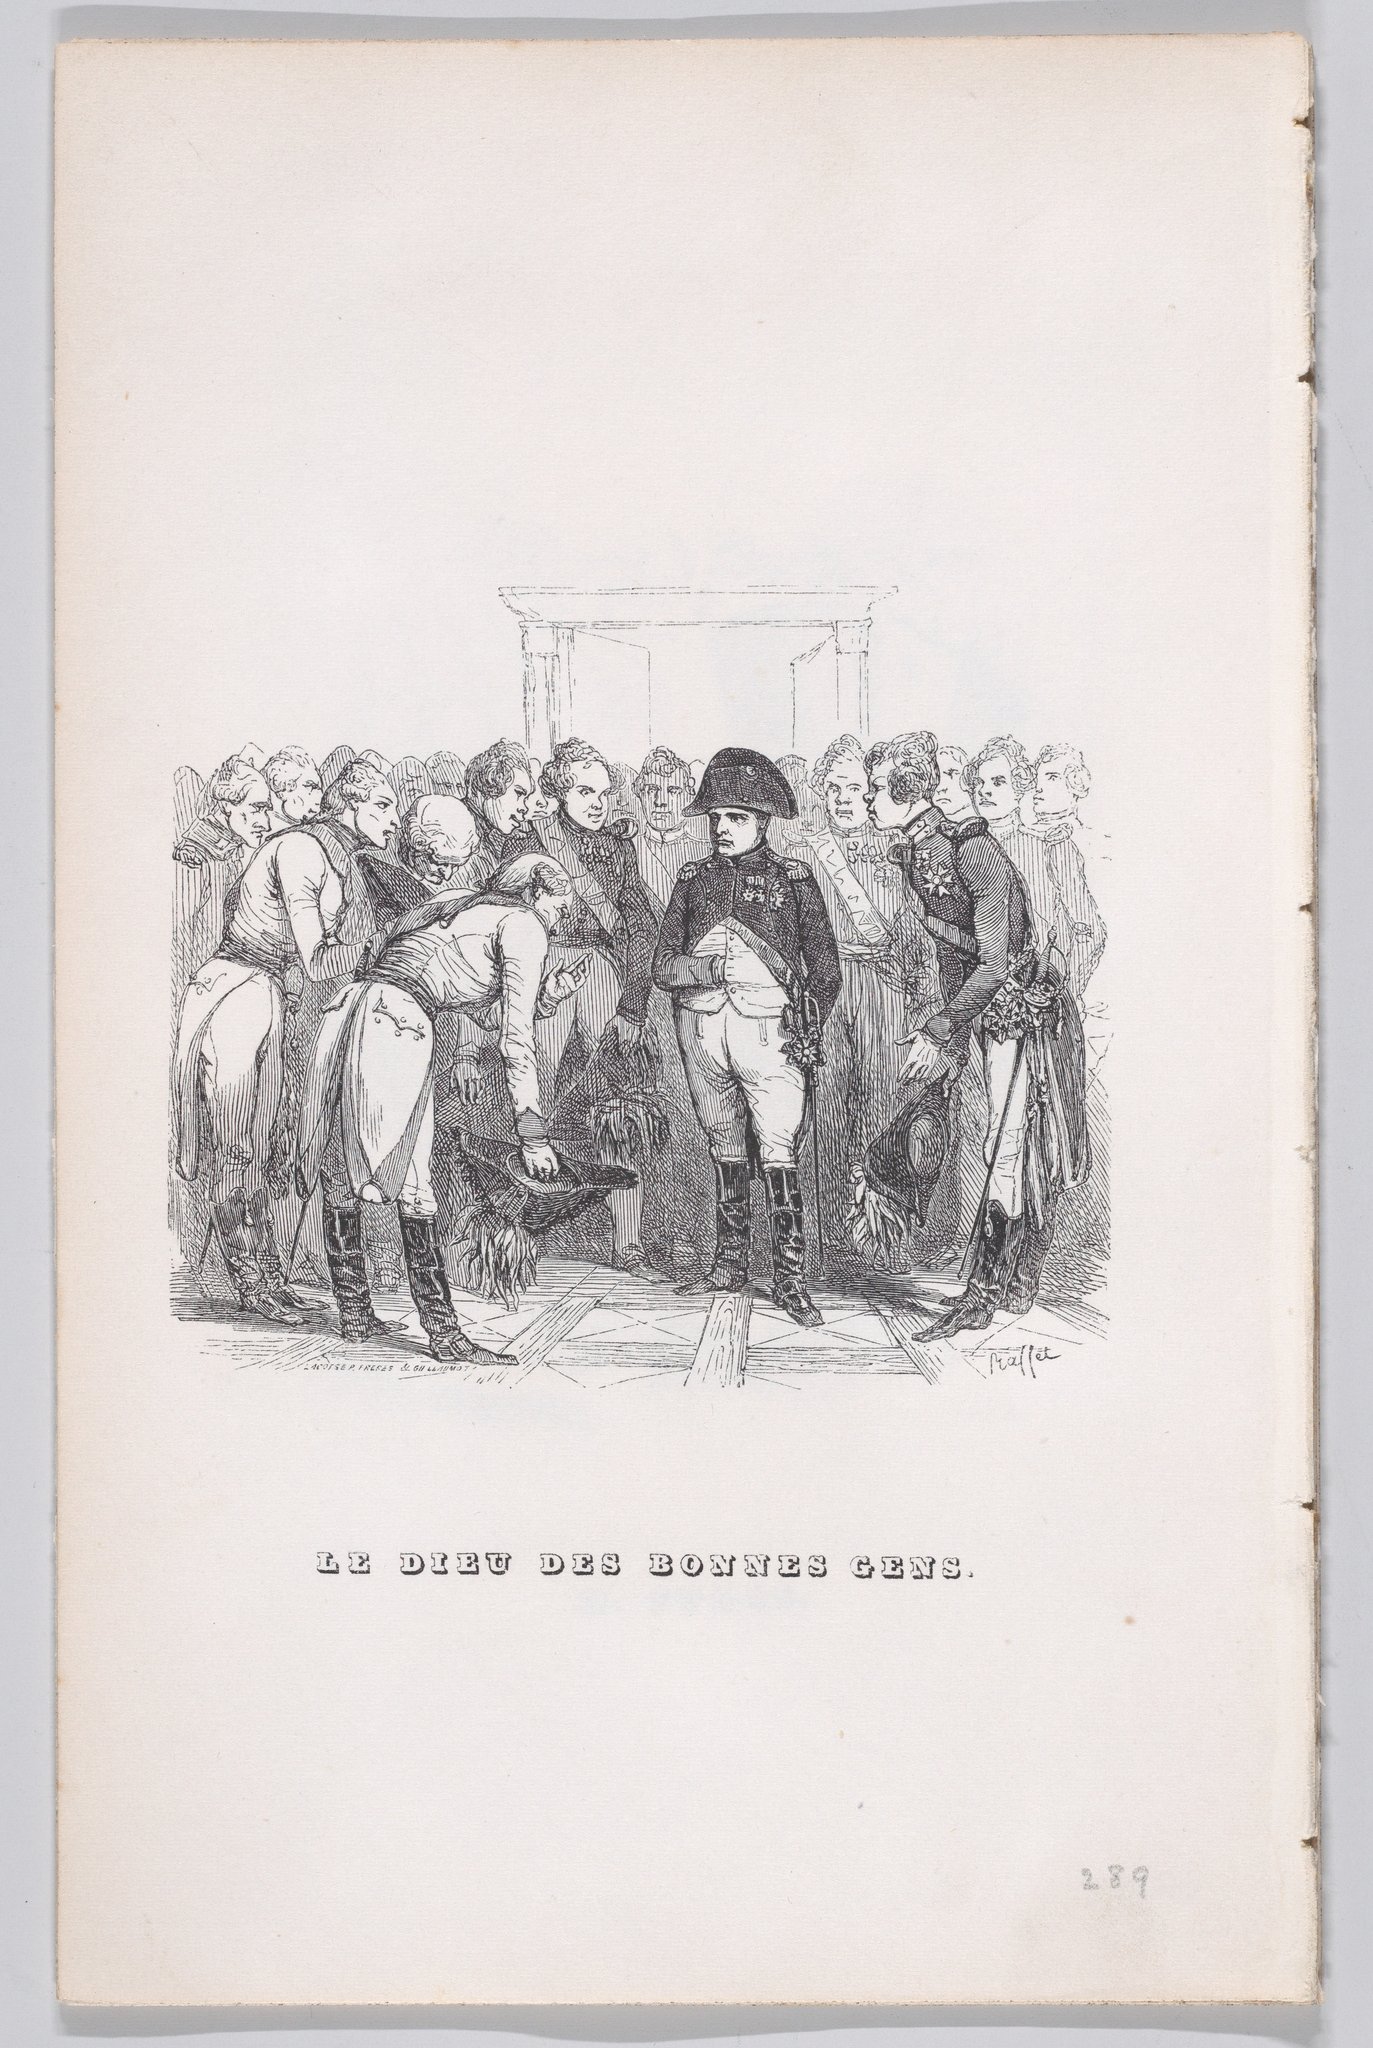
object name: print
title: The God of Good People, from "The Complete Works of Béranger"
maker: j. j. grandville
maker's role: illustrator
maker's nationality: french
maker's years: 1803-1847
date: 1836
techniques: engraving